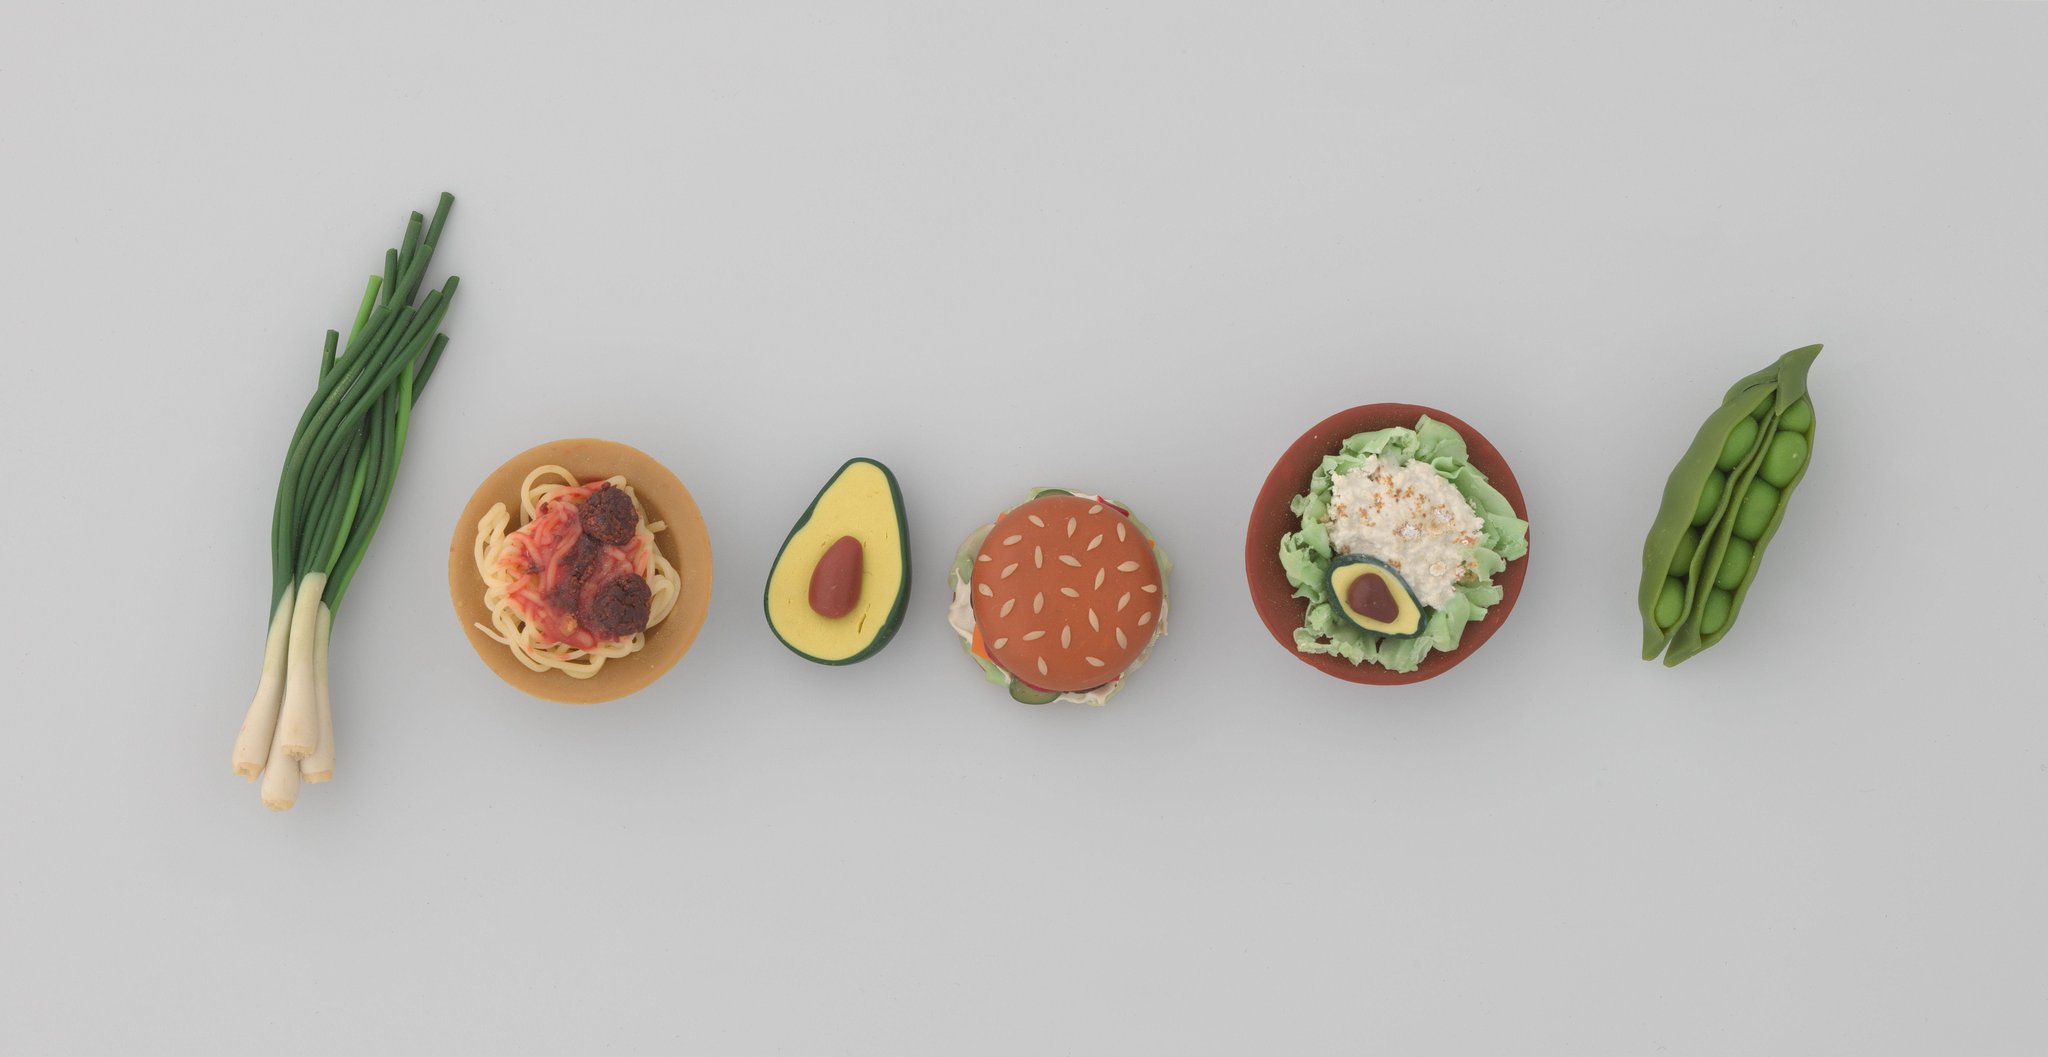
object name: brooch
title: Twee geopende peulen met daarin elk vijf doperwten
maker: Anonymous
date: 1970-1980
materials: metal, plastic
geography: united states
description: Broche van kunststof met haaksluiting van metaal.